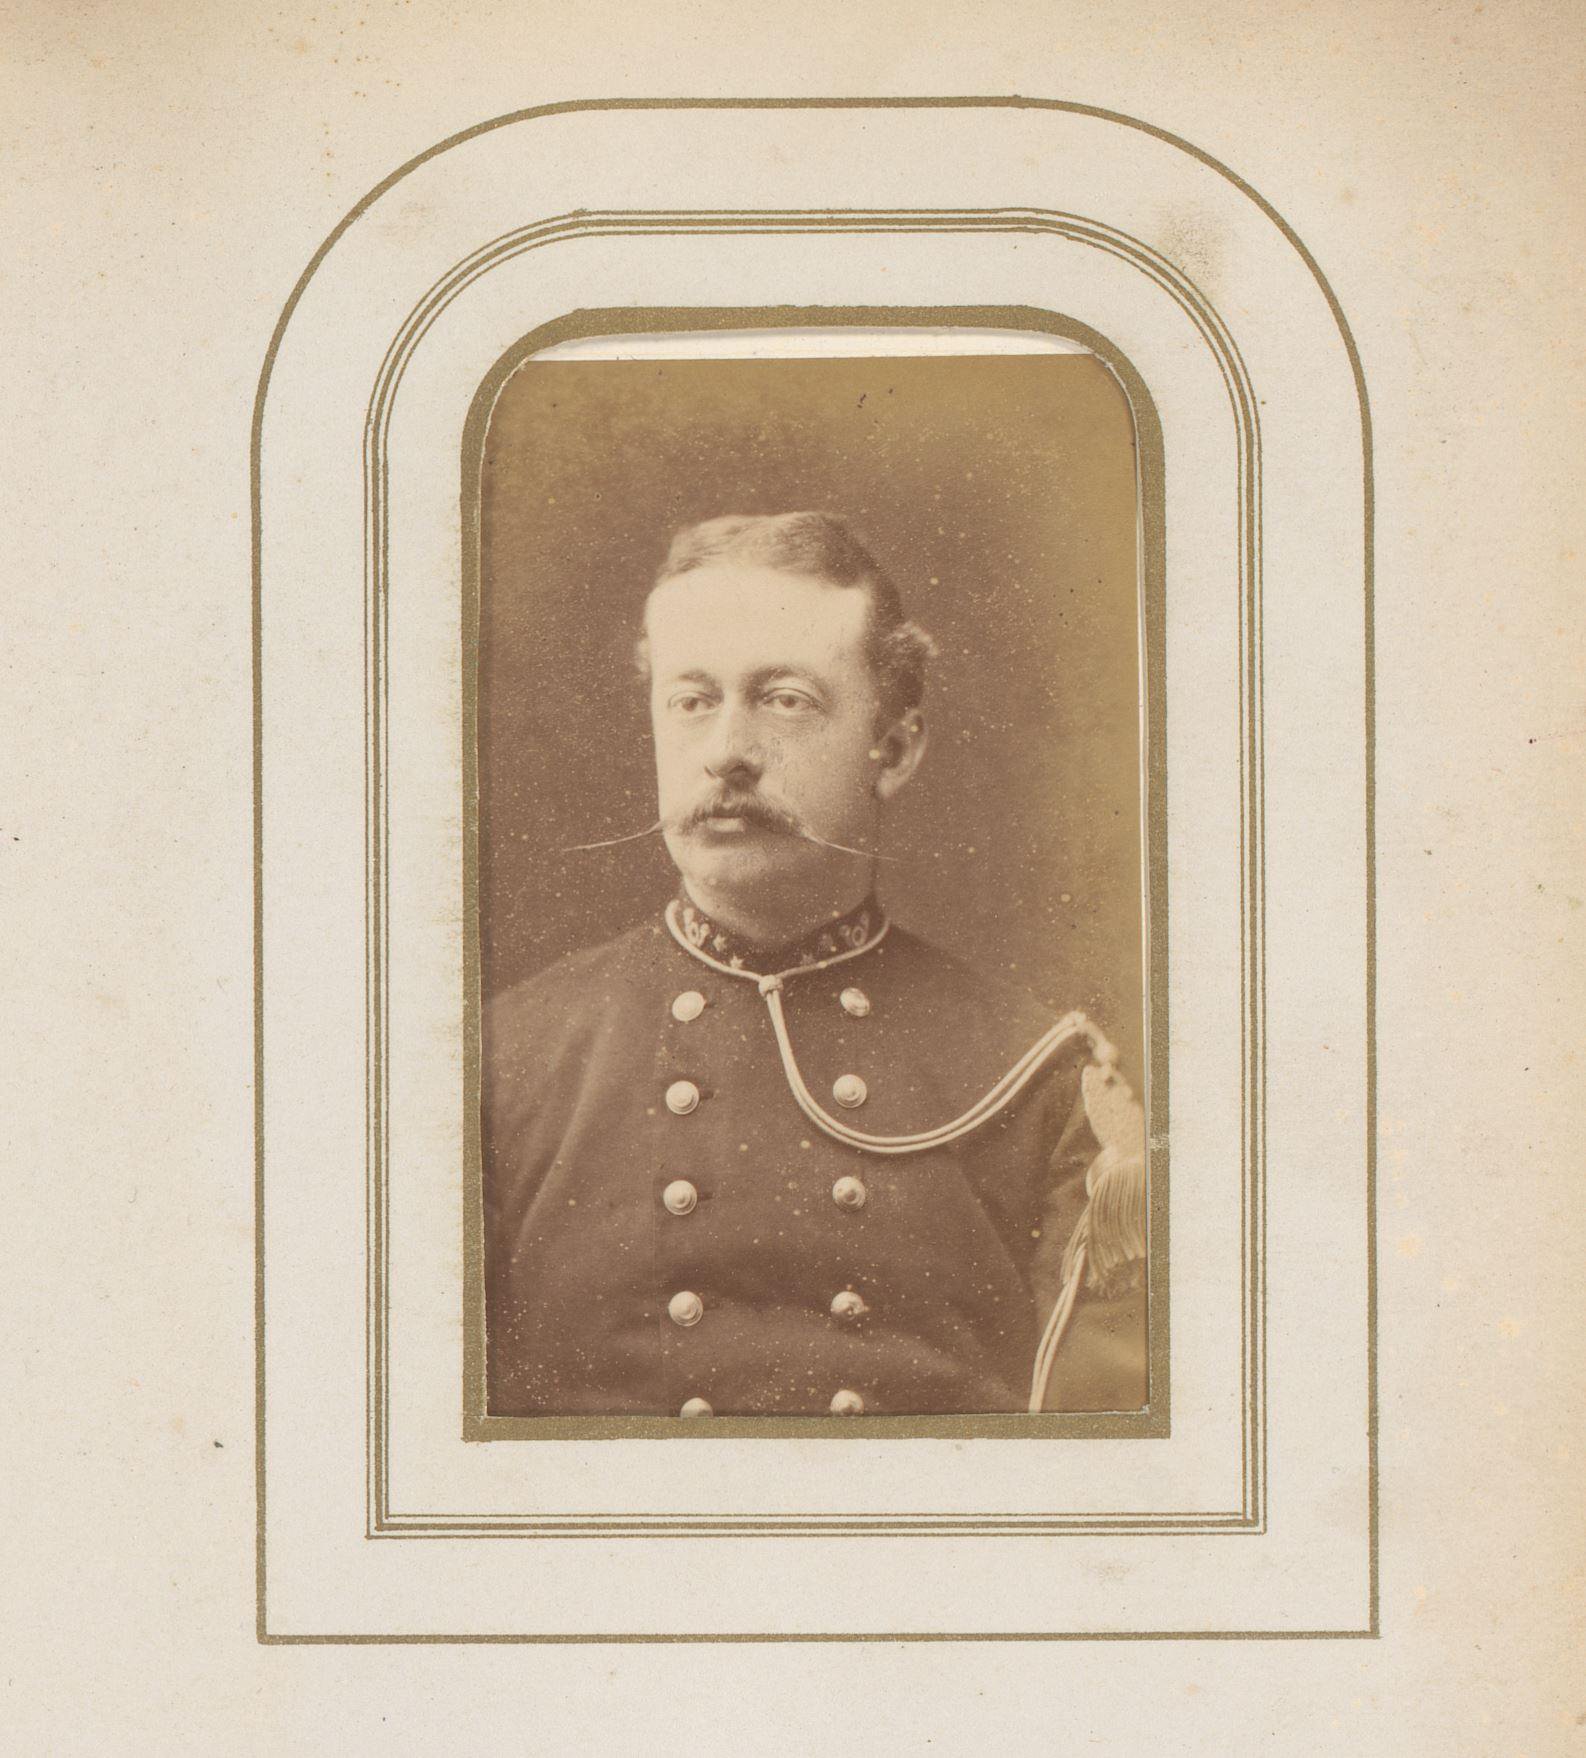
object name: album leaf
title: Portret van een man met snor in uniform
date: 1872-1900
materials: cardboard, photographic support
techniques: albumen print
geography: brussels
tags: moustache, historical persons, (military) uniforms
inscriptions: inscription: ‘Günther/ 23, Rue Neuve 23/ Bruxelles’